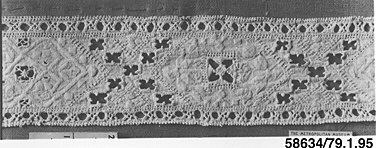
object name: strip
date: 1501-1600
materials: linen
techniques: embroidery